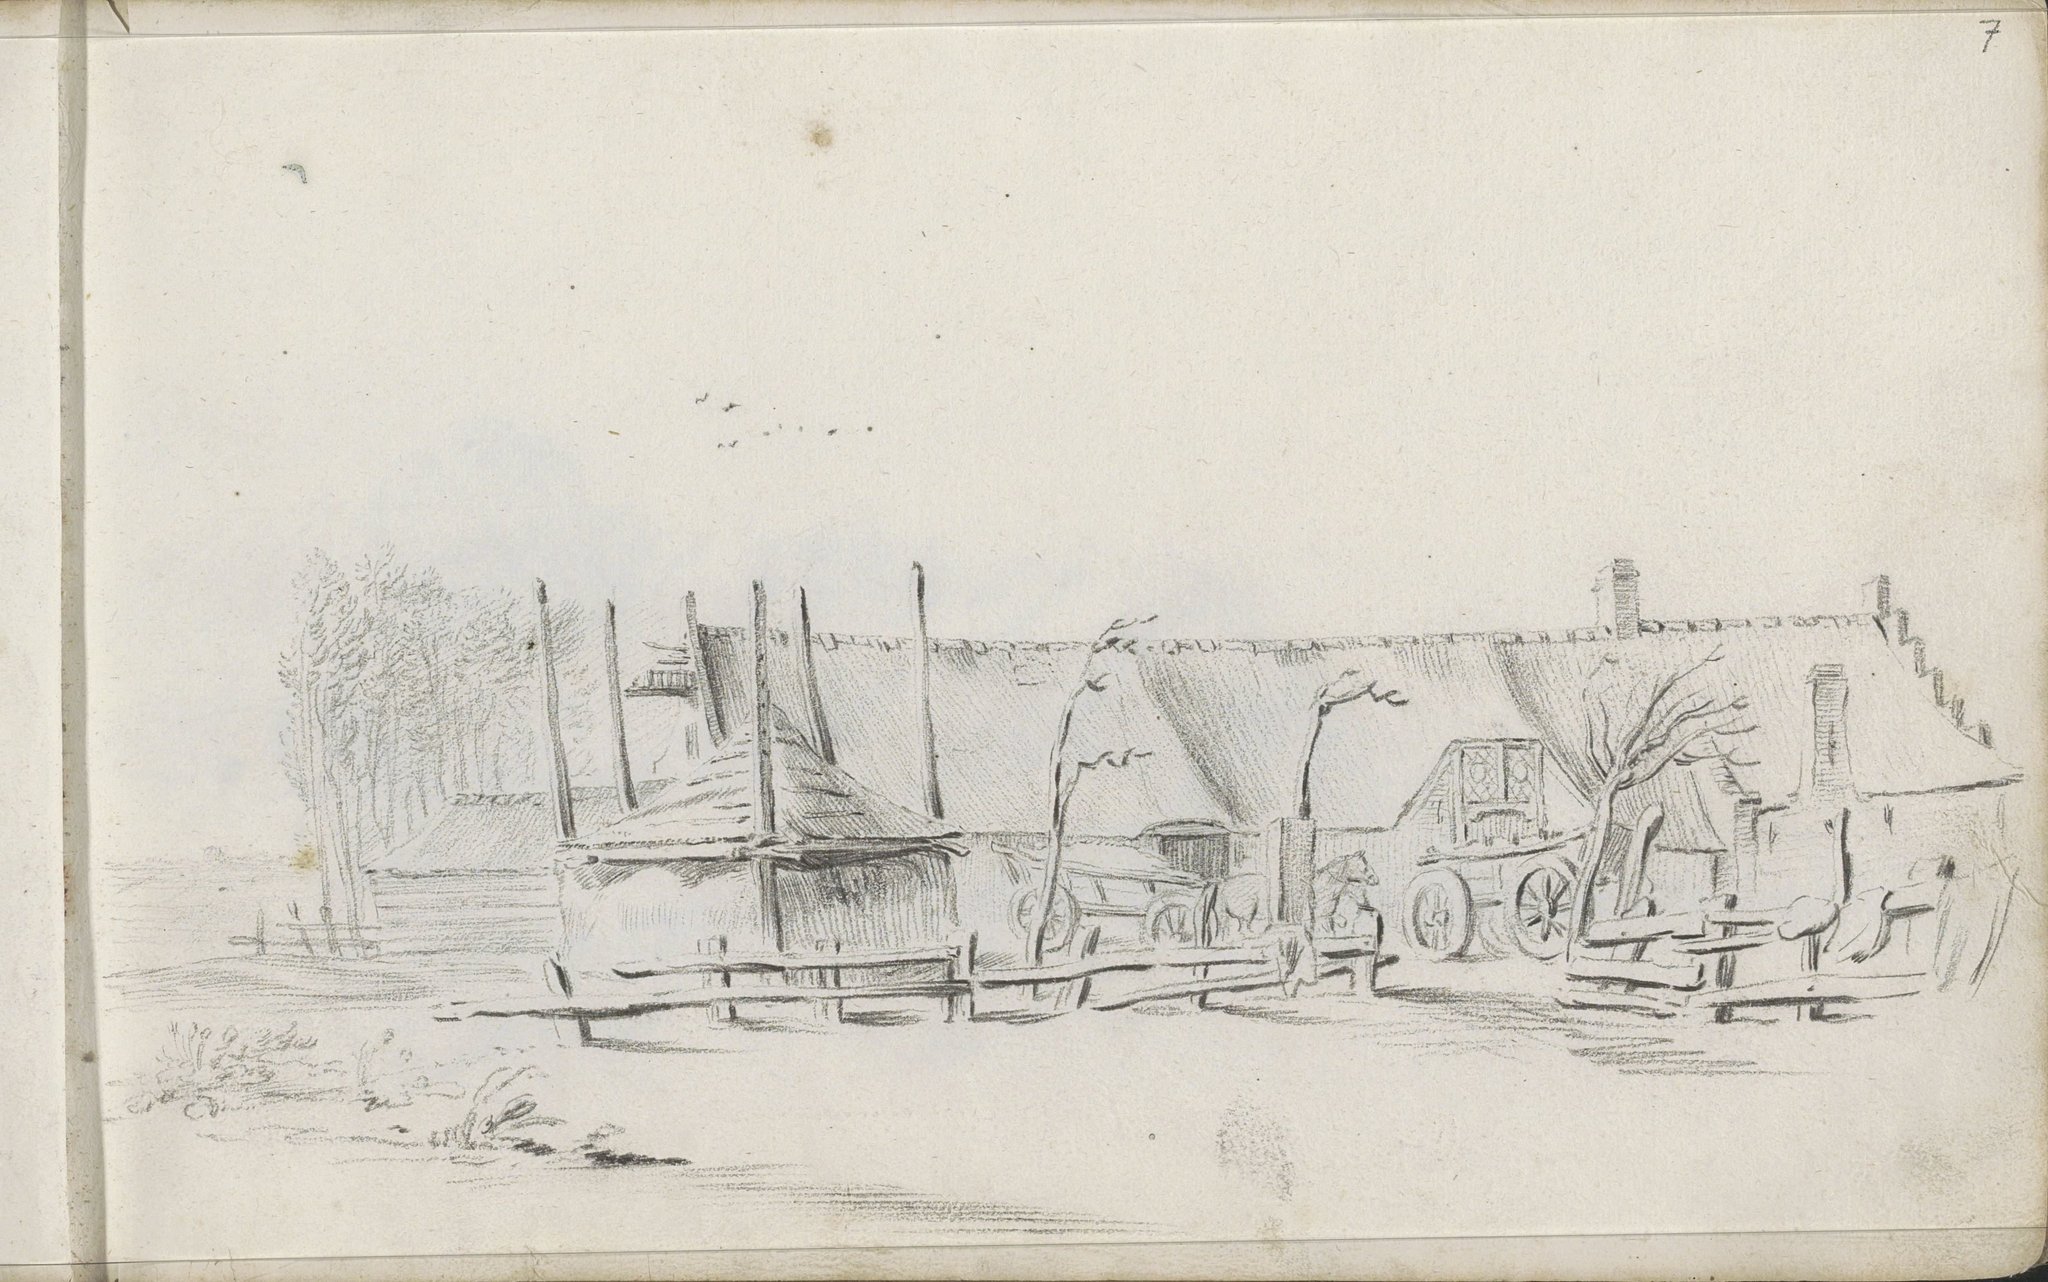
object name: sketchbook leaf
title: Boerenerf met een hooimijt en twee karren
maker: pieter moninckx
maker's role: draughtsman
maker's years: 1606-1686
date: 1645-1646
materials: chalk, paper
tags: hay-stack, (farm) wagon, freight wagon, cart, farm (building)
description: Blad 7 recto uit een schetsboek met 39 bladen.